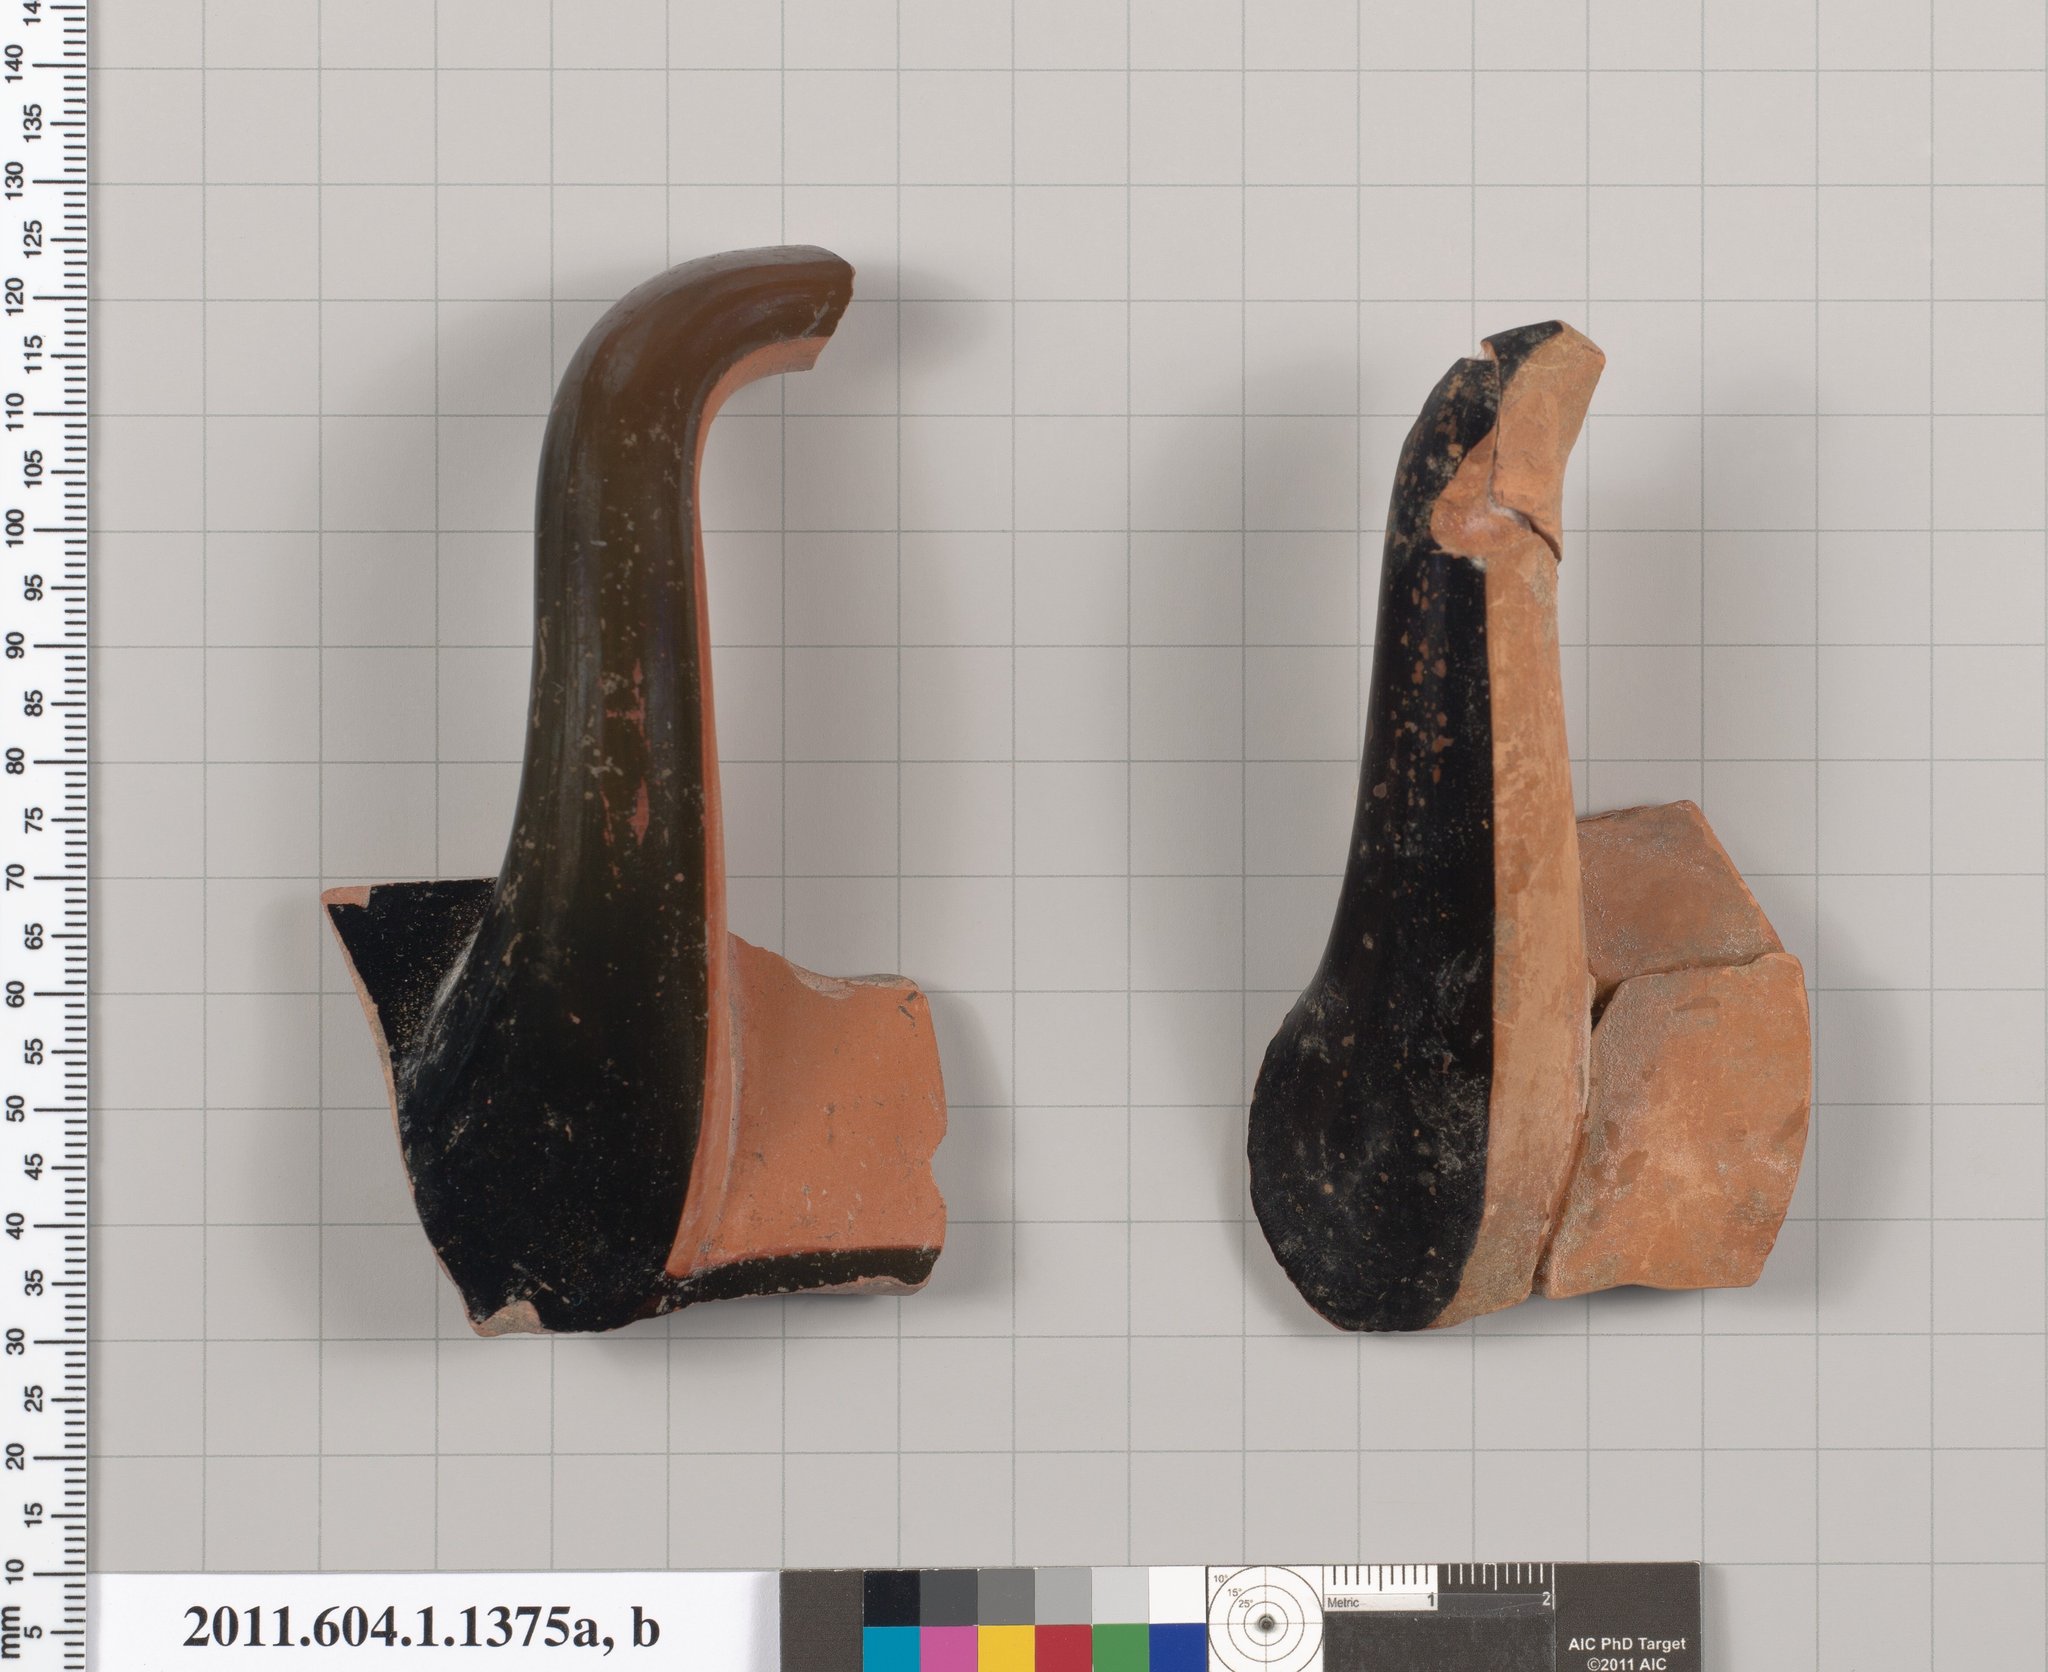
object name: kylix fragment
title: Terracotta fragments of kylikes (drinking cups)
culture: greek, attic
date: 500-401 BCE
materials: terracotta